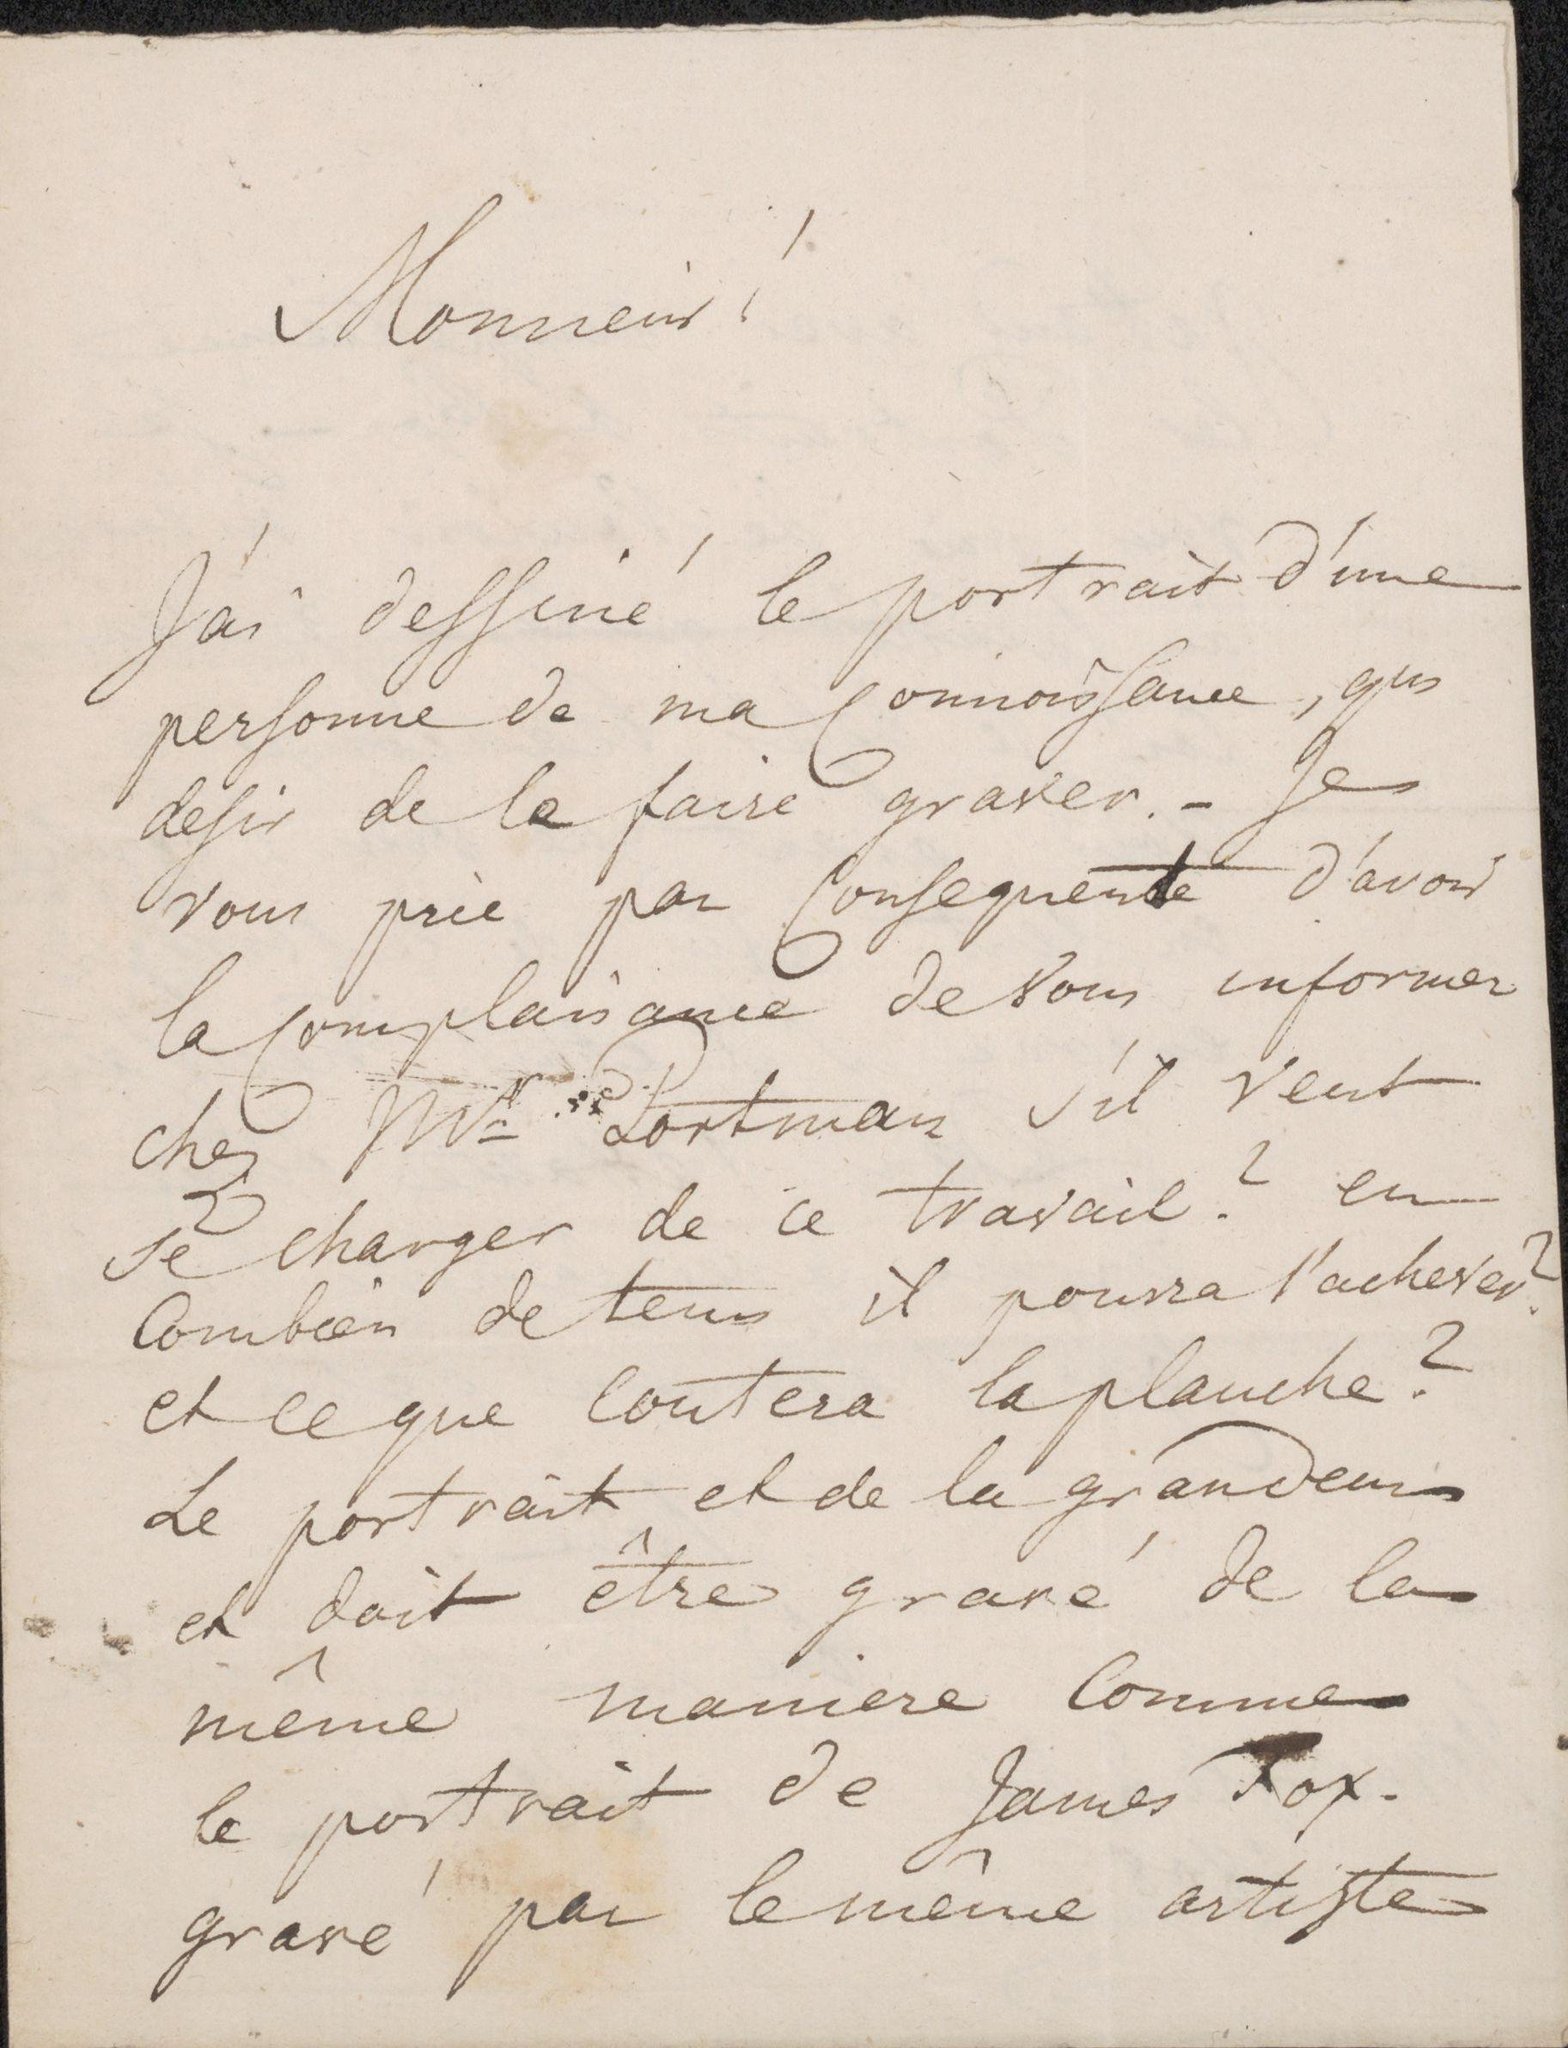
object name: letter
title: Brief aan Evert Maaskamp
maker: otto baron howen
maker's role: draughtsman, print maker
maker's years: 1774-1848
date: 1808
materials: ink, paper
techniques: pen, writing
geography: utrecht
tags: amsterdam, painter, publisher, evert maaskamp, drawing, the graphic arts, historical persons (portraits and scenes from the life)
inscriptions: watermark, collector's mark: Lugt 2228